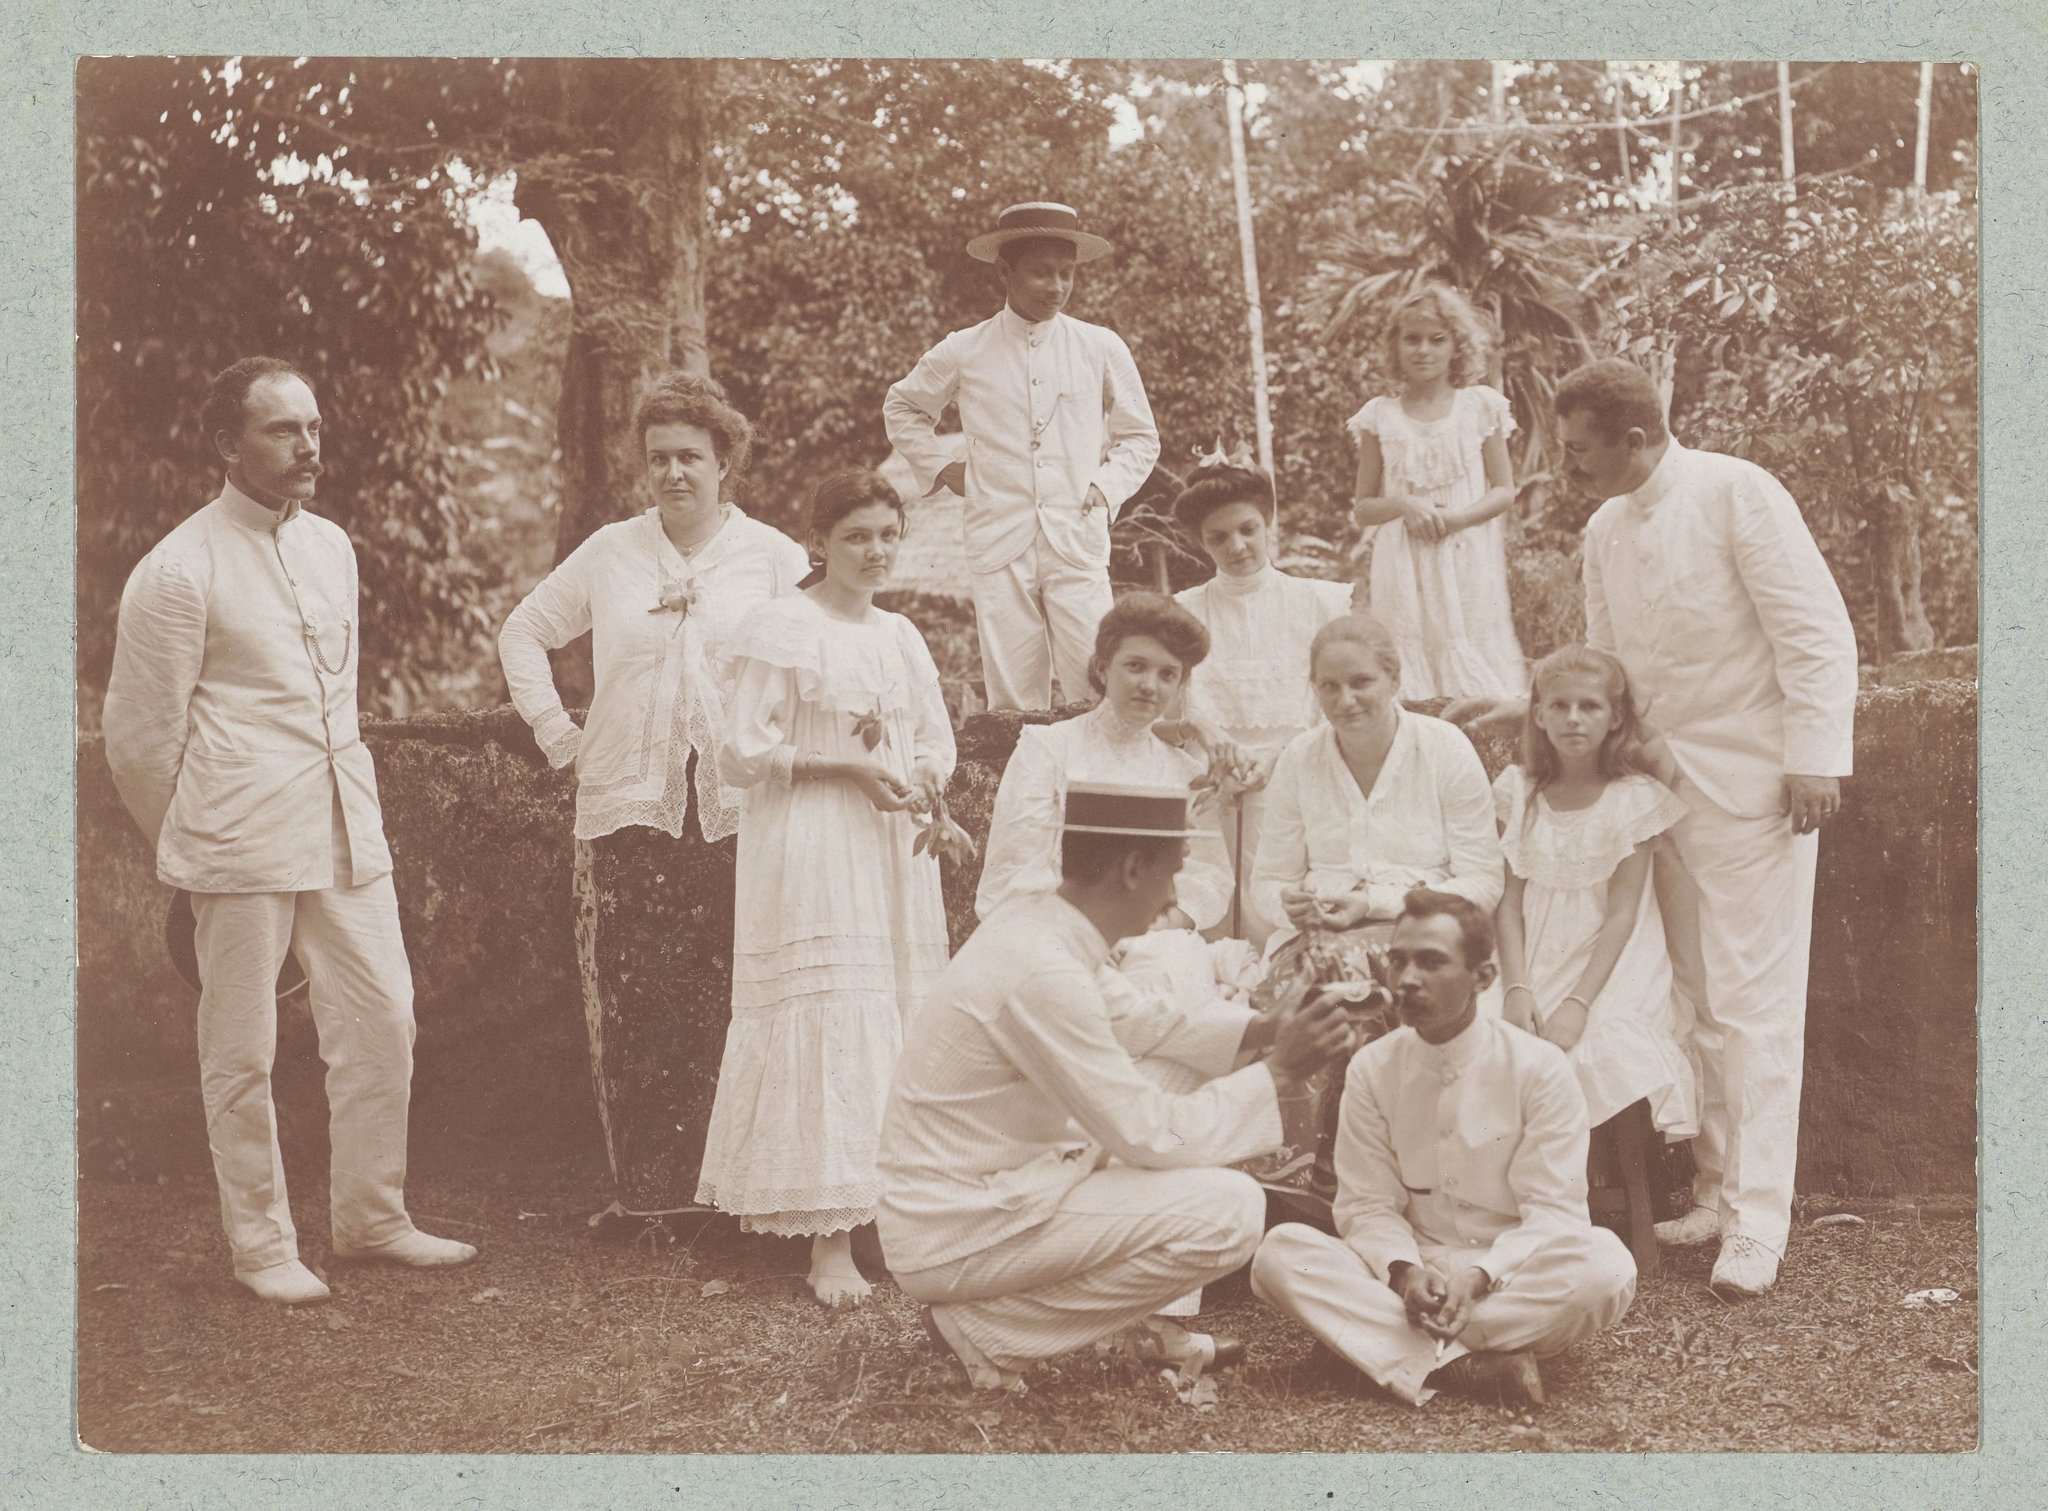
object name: photograph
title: Photographieën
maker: frits freerks fontein fz.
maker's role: fotograaf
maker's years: 1882-1928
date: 1910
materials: cardboard, paper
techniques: gelatin silver print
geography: madura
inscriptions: caption: ‘Batoewan bij Soemenep 1910’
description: De mannen dragen witte tropenuniformen waarvan een man met tropenhelm, twee andere mannen dragen een strooien hoed, de vrouwen dragen witte jurken of batik rokken met witte hes. Foto uit album 'Photographieën".